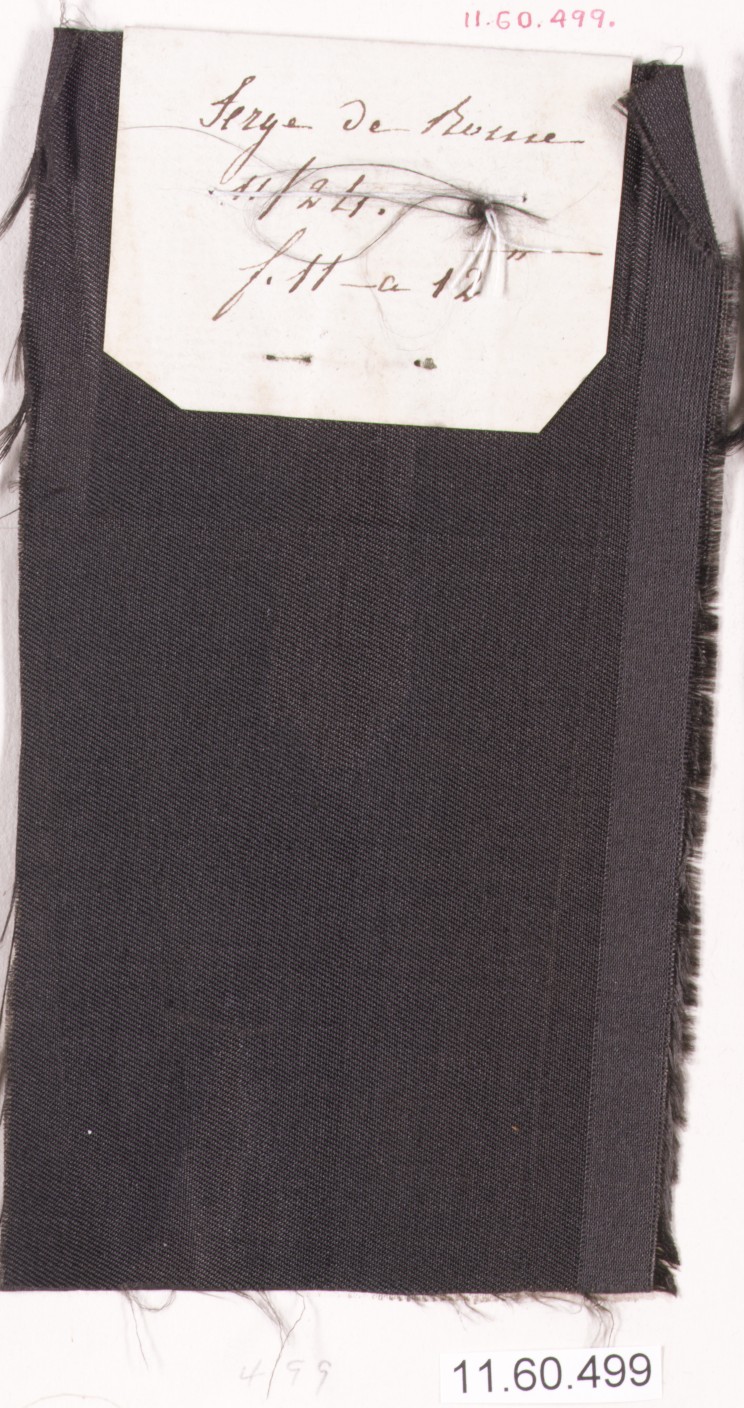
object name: sample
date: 1801-1850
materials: silk